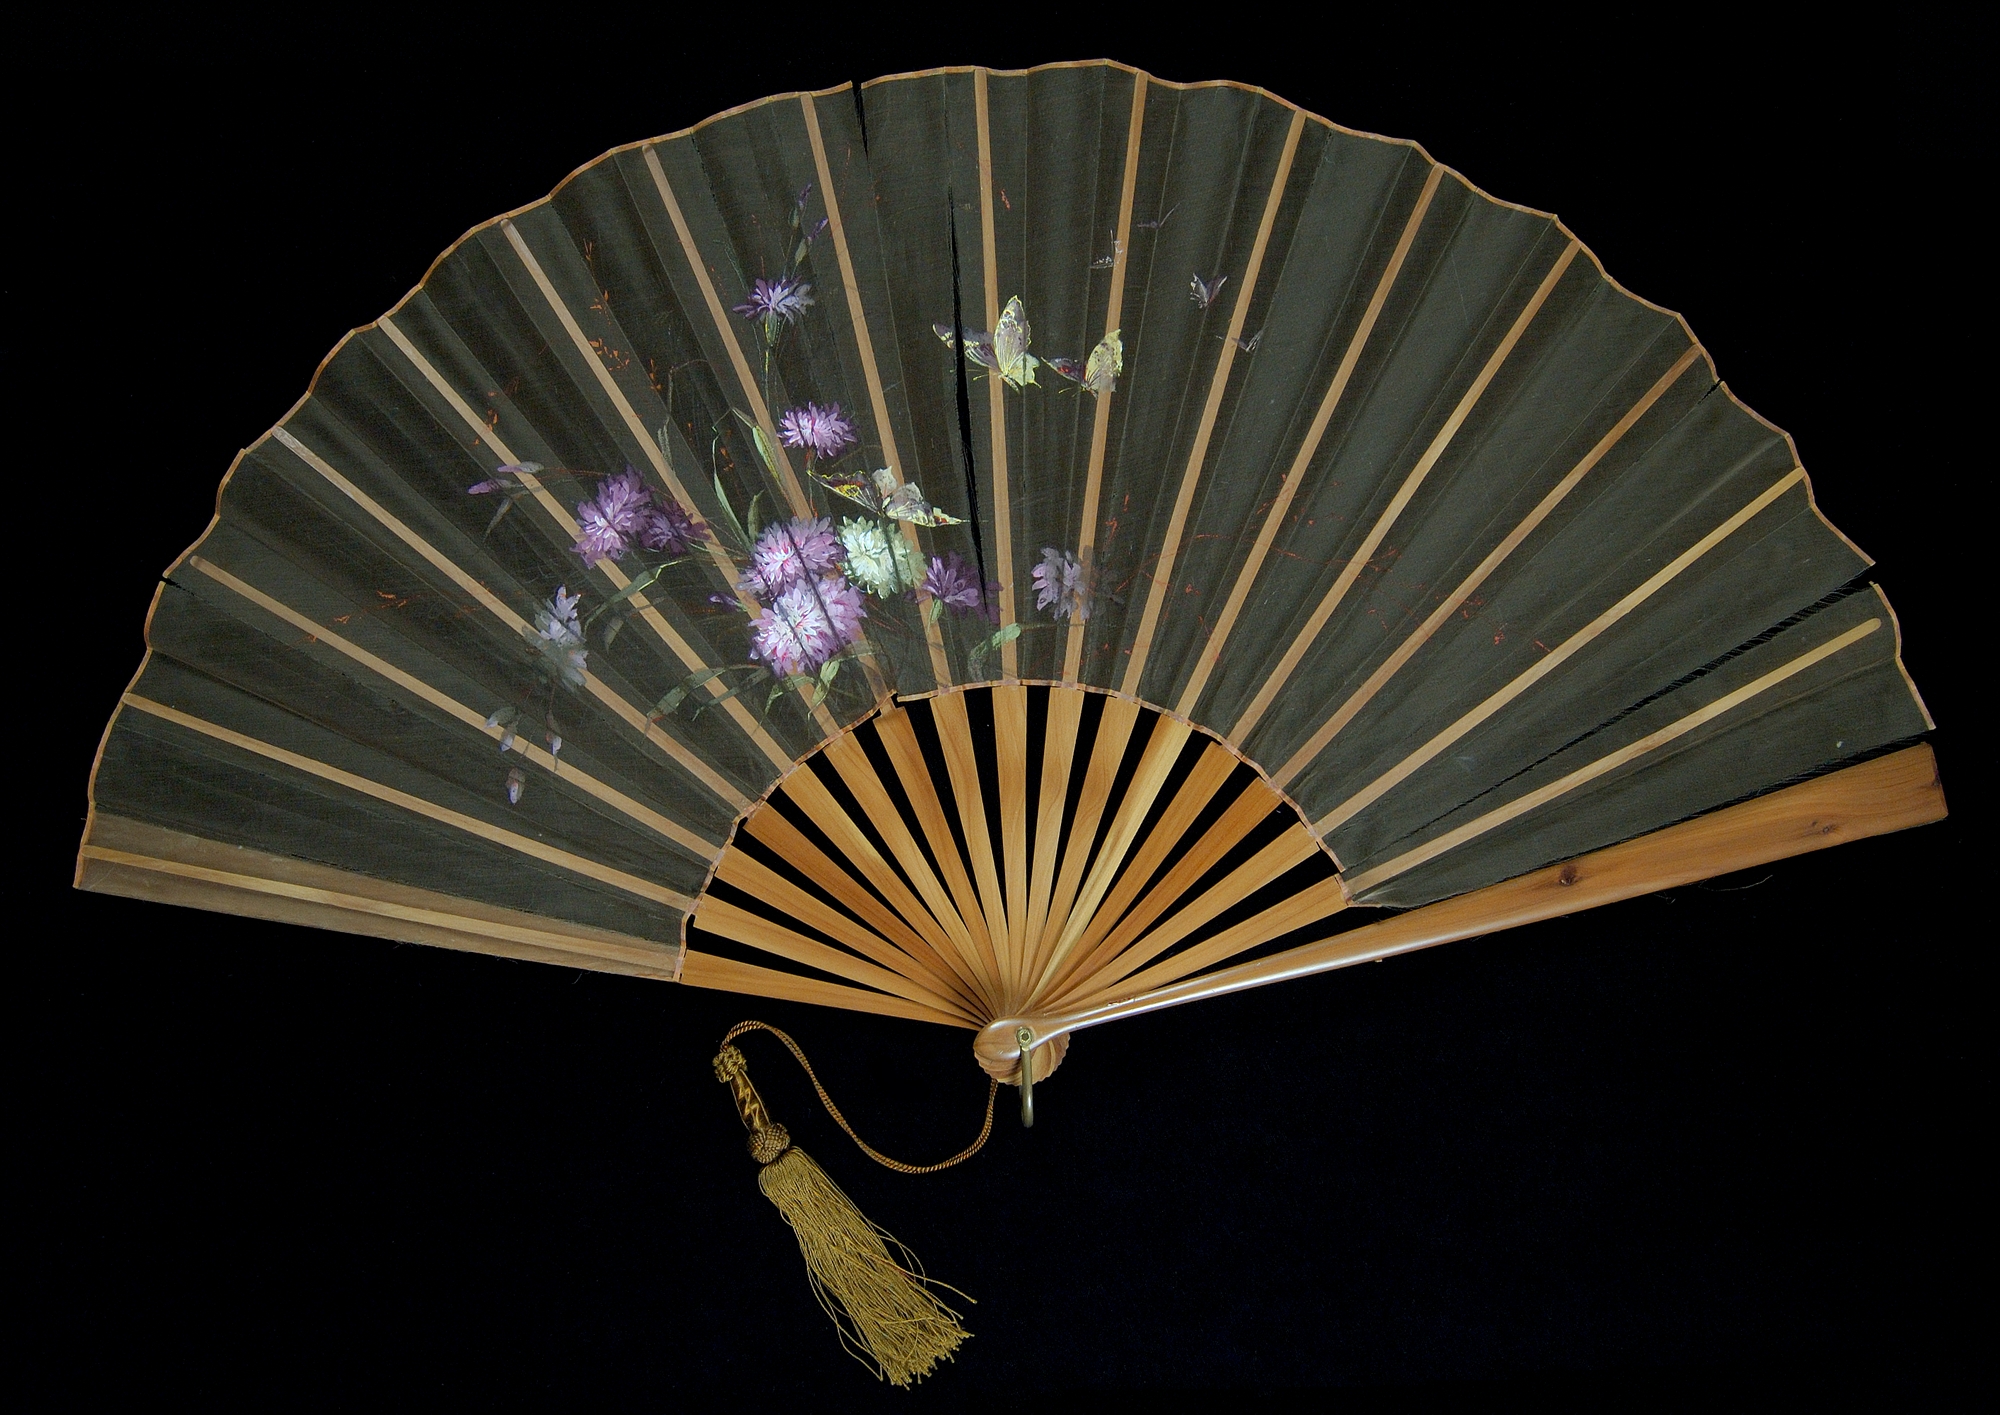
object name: fan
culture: french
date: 1885-1895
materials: metal, silk, wood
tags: butterflies,flowers